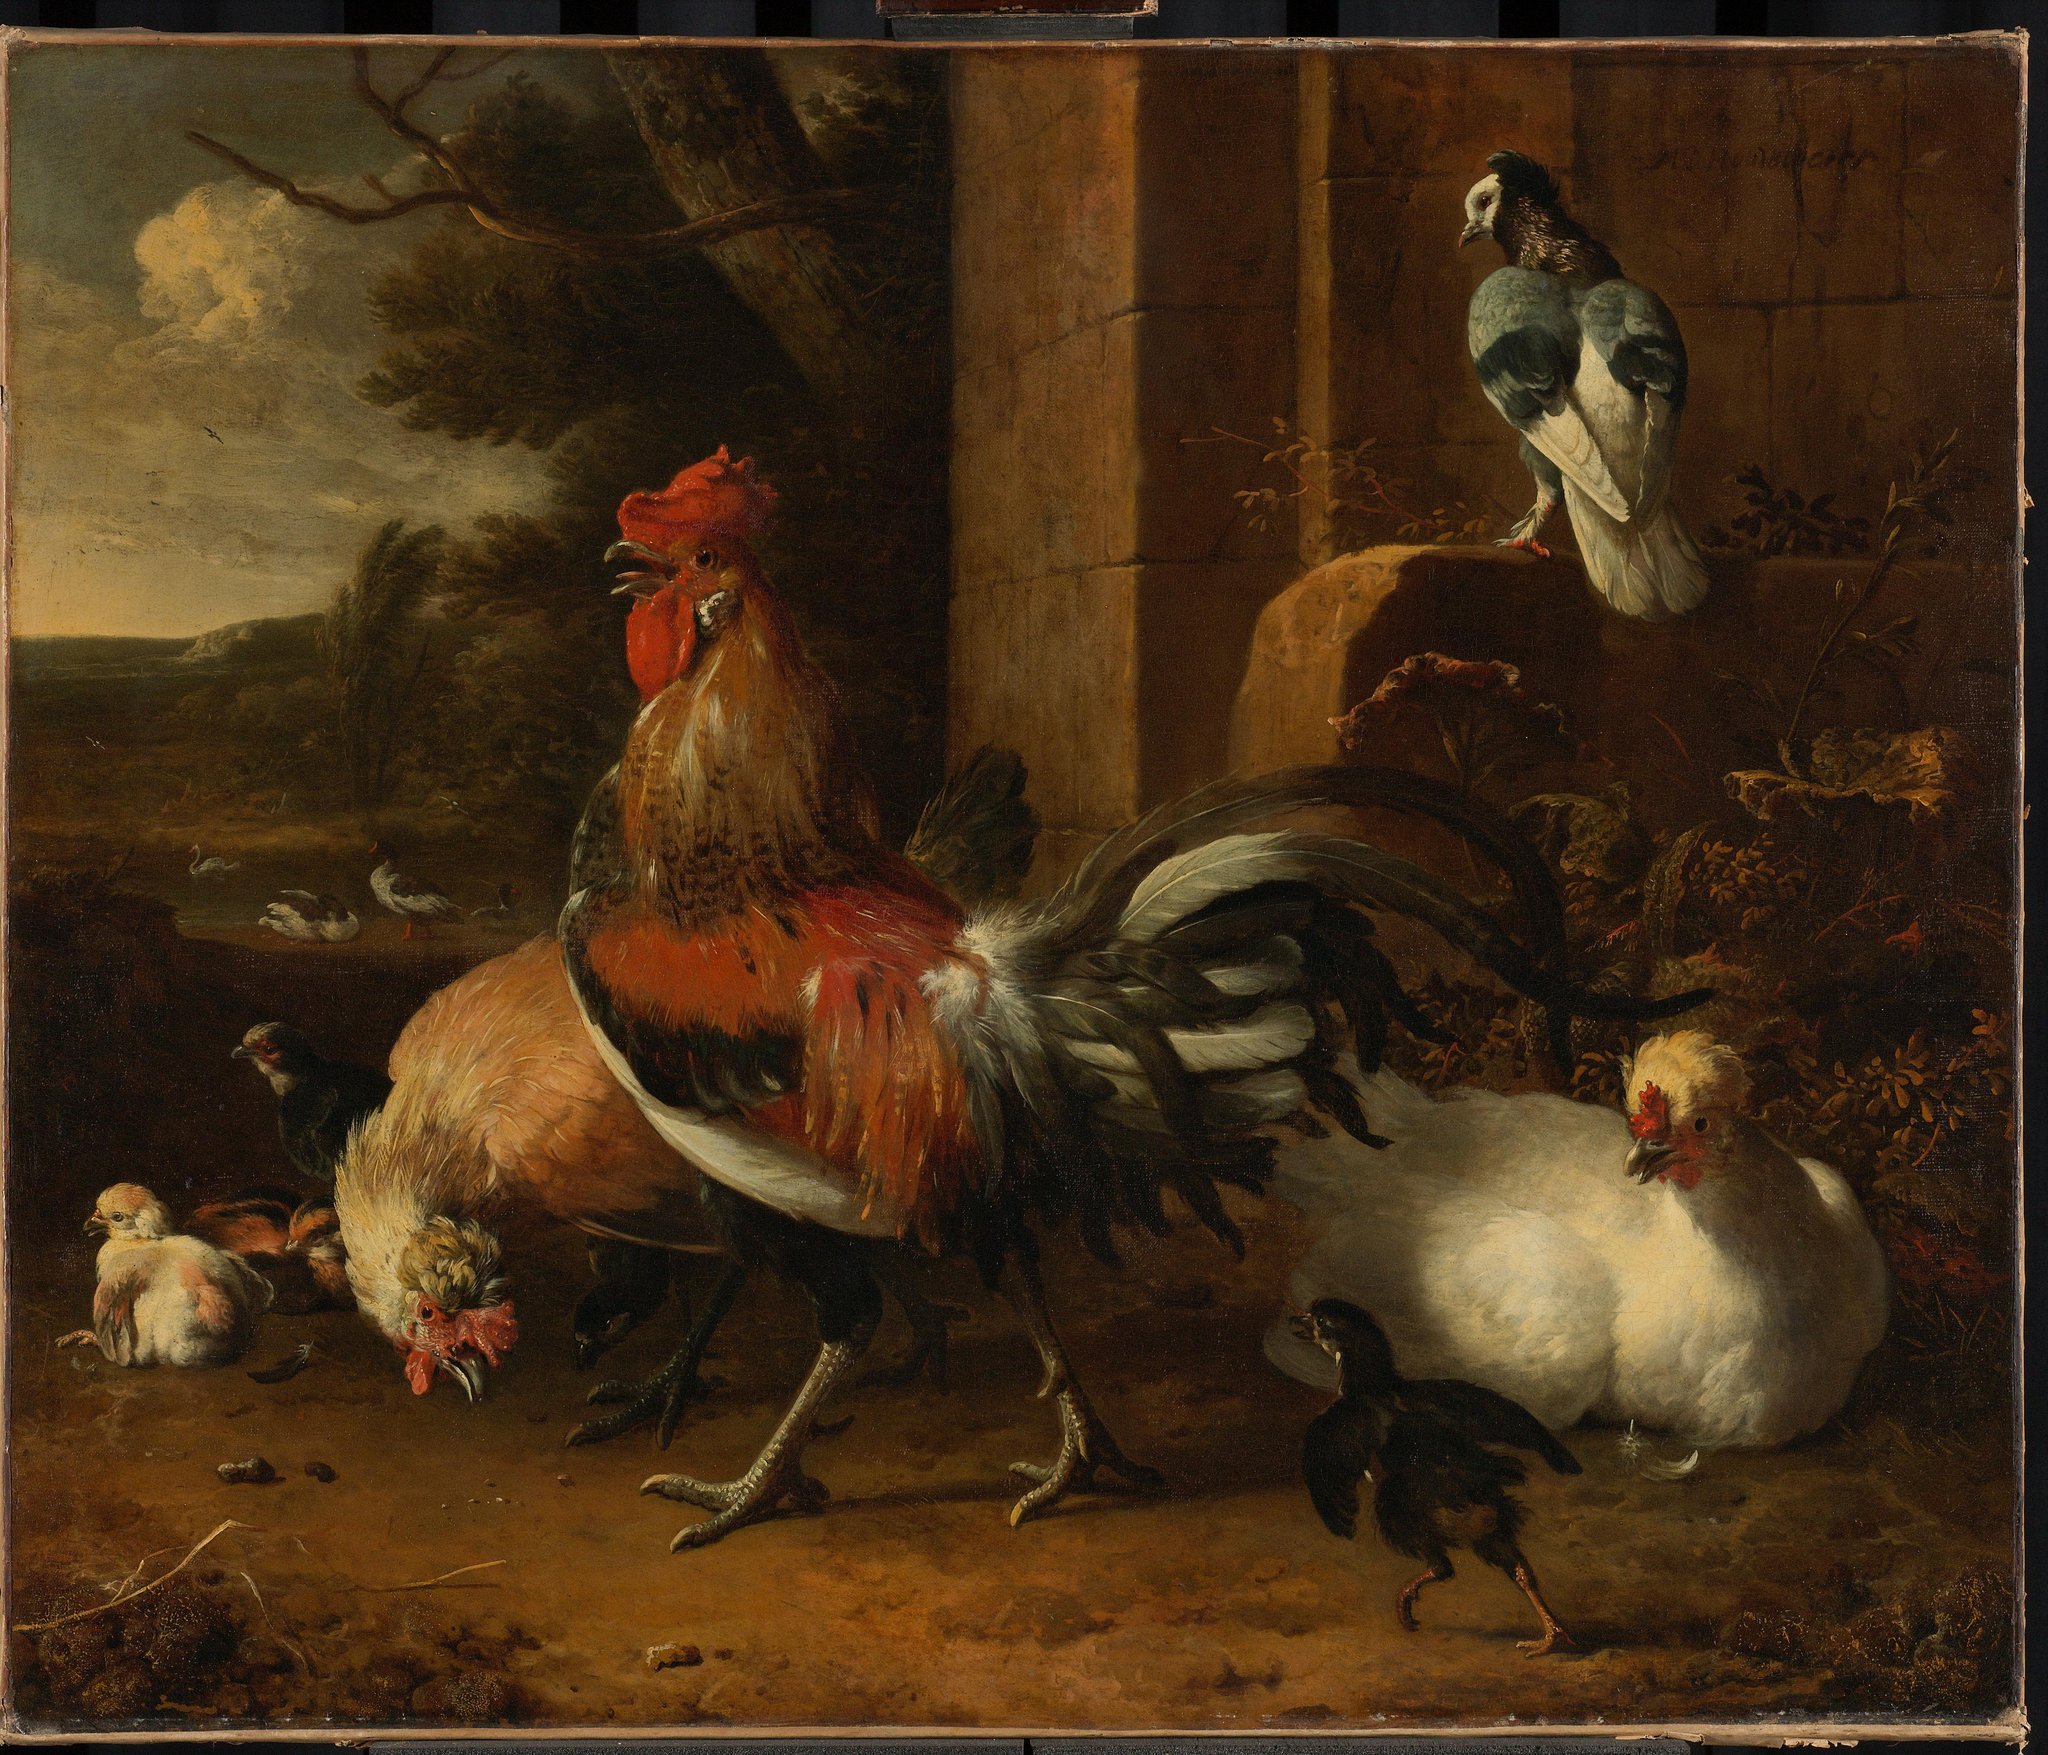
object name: painting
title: A Poultry Yard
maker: melchior d hondecoeter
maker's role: draughtsman, painter, print maker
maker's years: 1636-1695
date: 1660-1665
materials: canvas, oil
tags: fowl (cock, hen, chicken, etc.)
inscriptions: signature: ‘M D Hondecoeter’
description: Hoenderhof met een haan omringd door enkele kippen en kuikens. Rechts zit een duif op een steen. Links op de achtergrond een vijver met eenden.